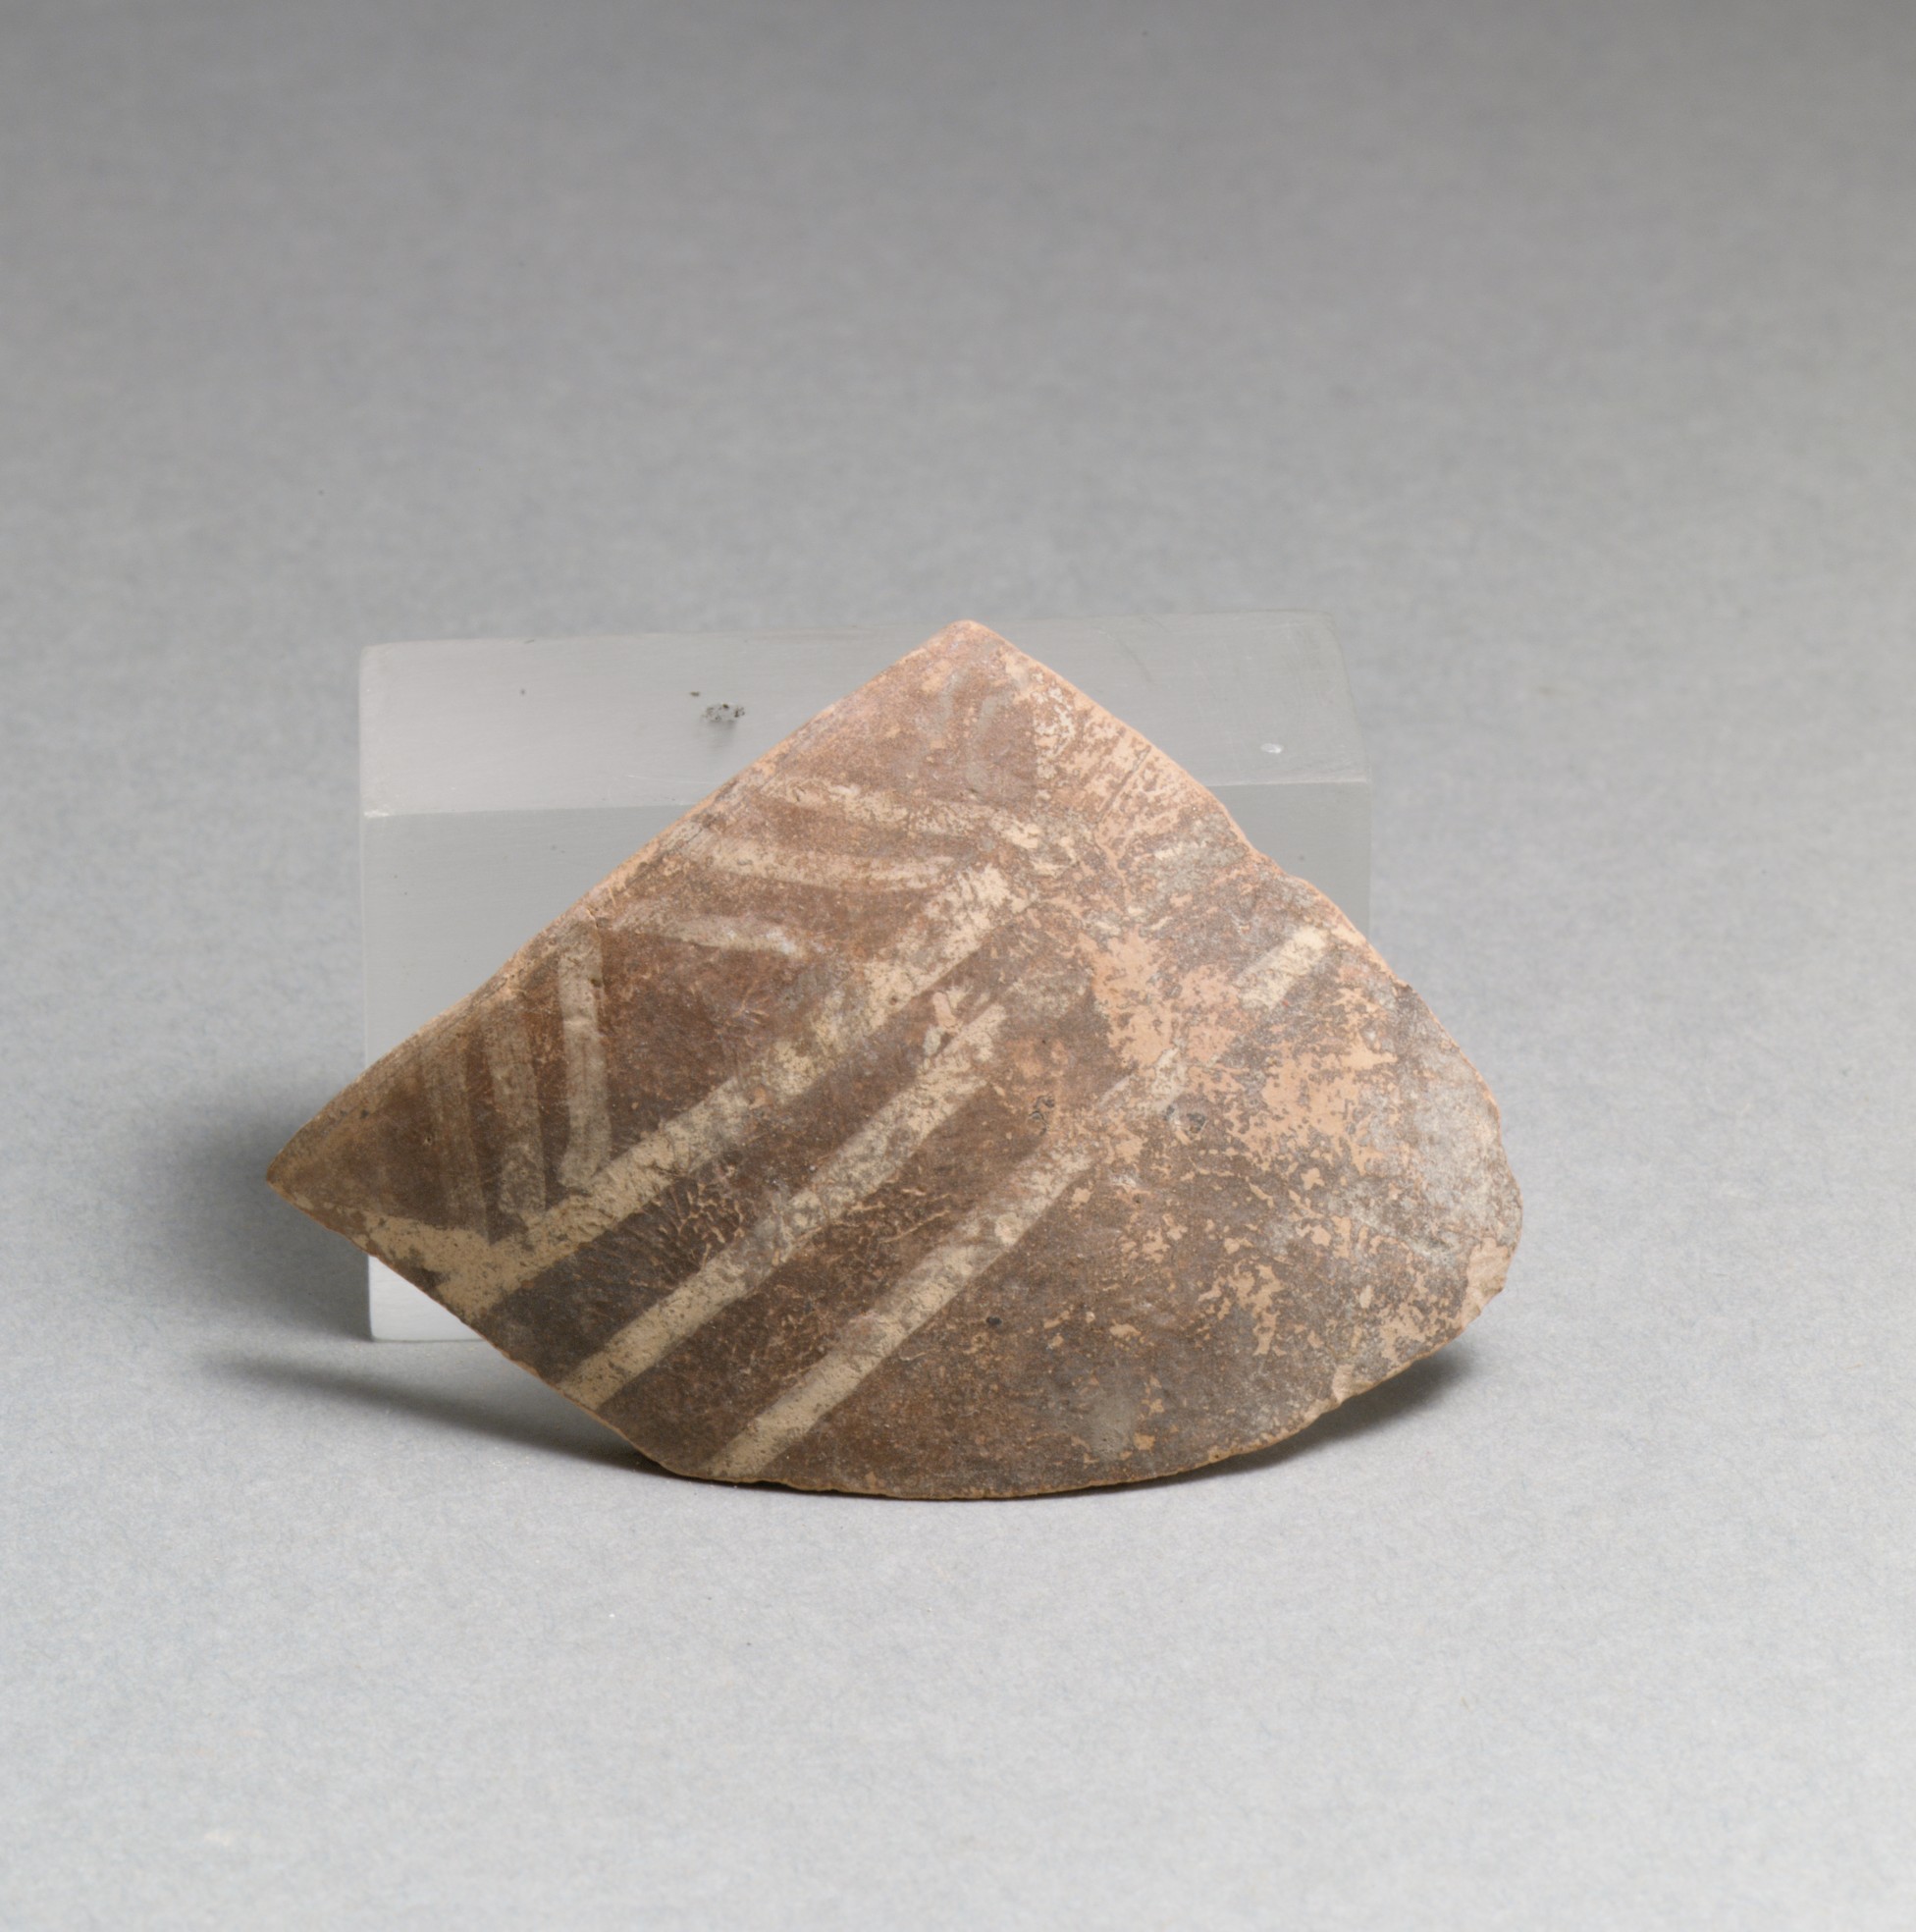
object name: vase fragment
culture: minoan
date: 2600-2000 BCE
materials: terracotta